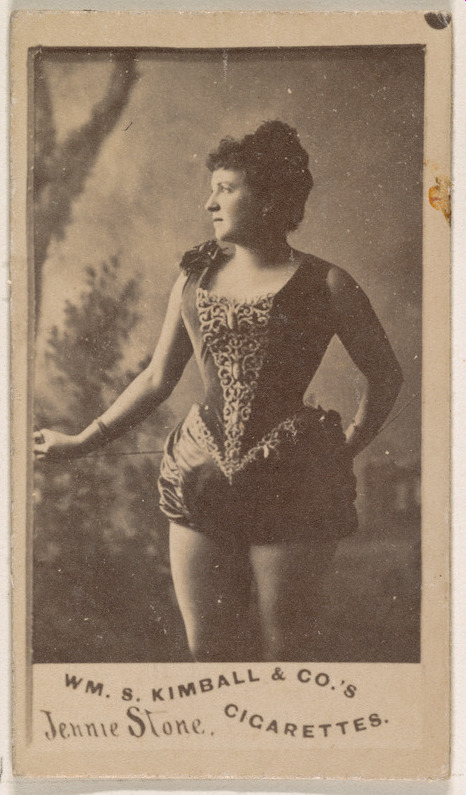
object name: photograph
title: Jennie Stone, from the Actresses series (N203) issued by Wm. S. Kimball & Co.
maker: william s. kimball & company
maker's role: publisher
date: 1889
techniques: color lithograph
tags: portraits,women,actresses